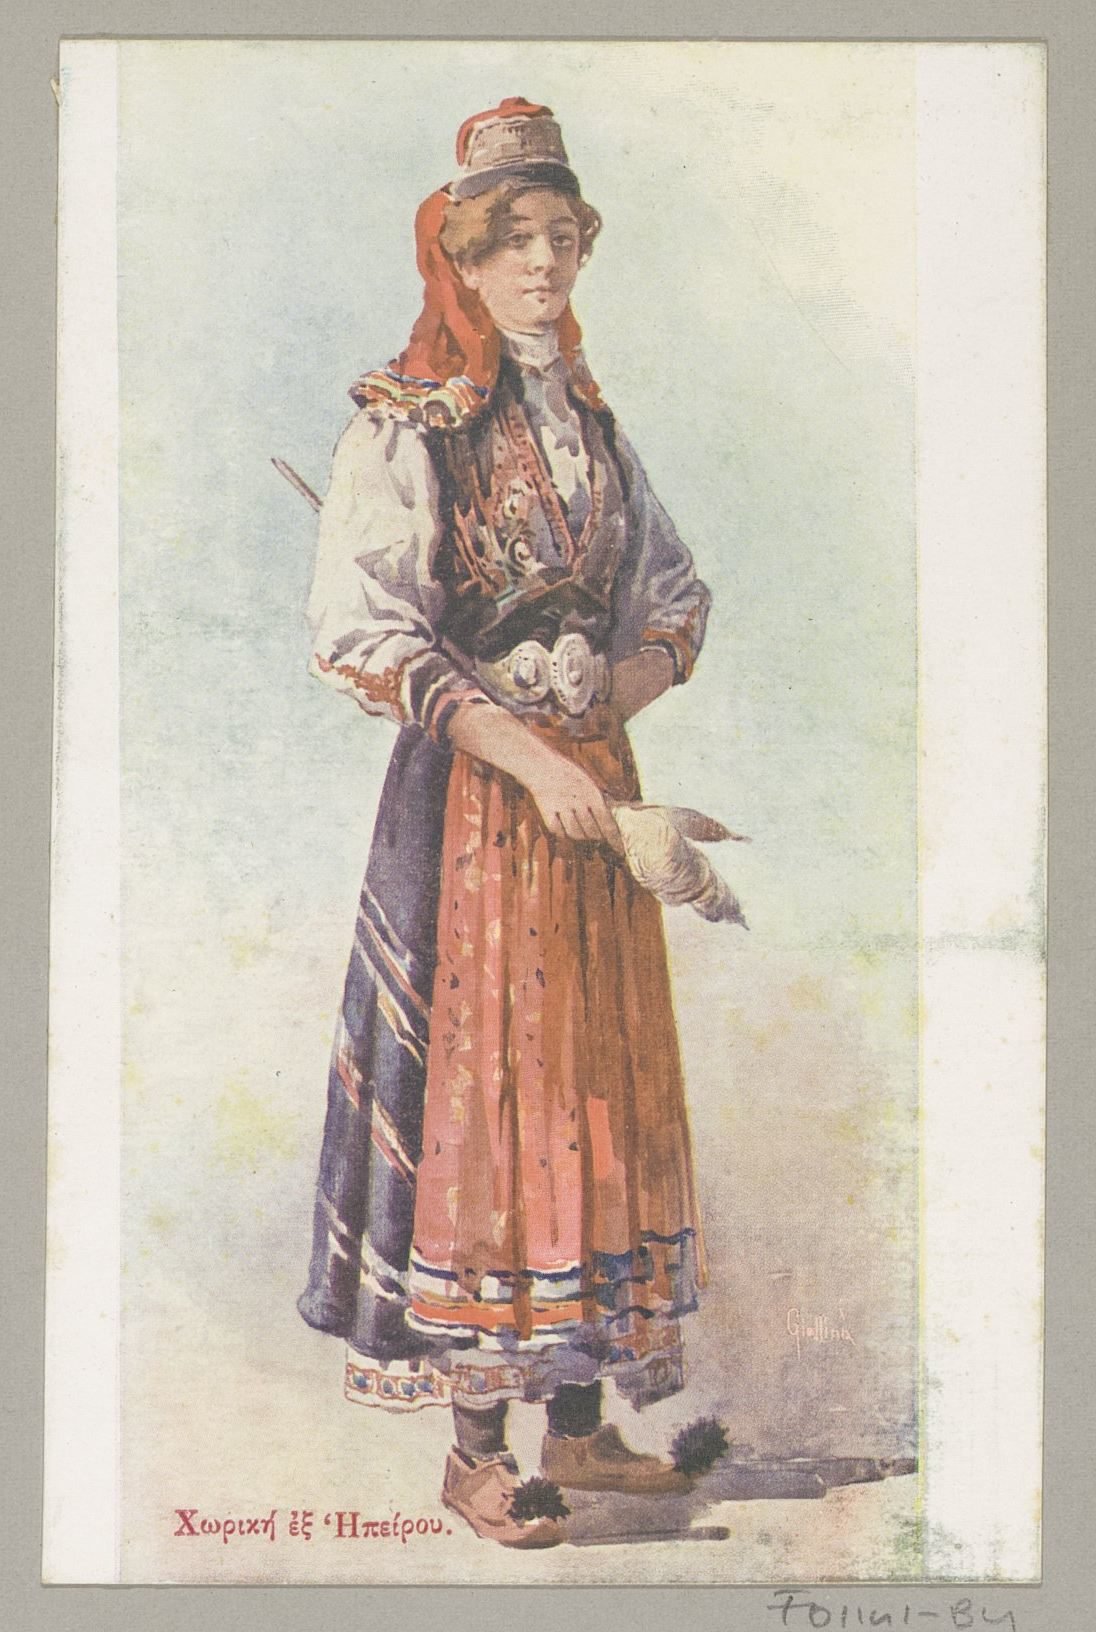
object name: ansichtkaart, prentbriefkaart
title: Portret van een vrouw in Griekse klederdracht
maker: Anonymous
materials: paper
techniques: color autotype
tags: folk costume, regional costume (+ women's clothes)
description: Onderdeel van Fotoalbum van een reis door Zuid-Europa en het Midden-Oosten.